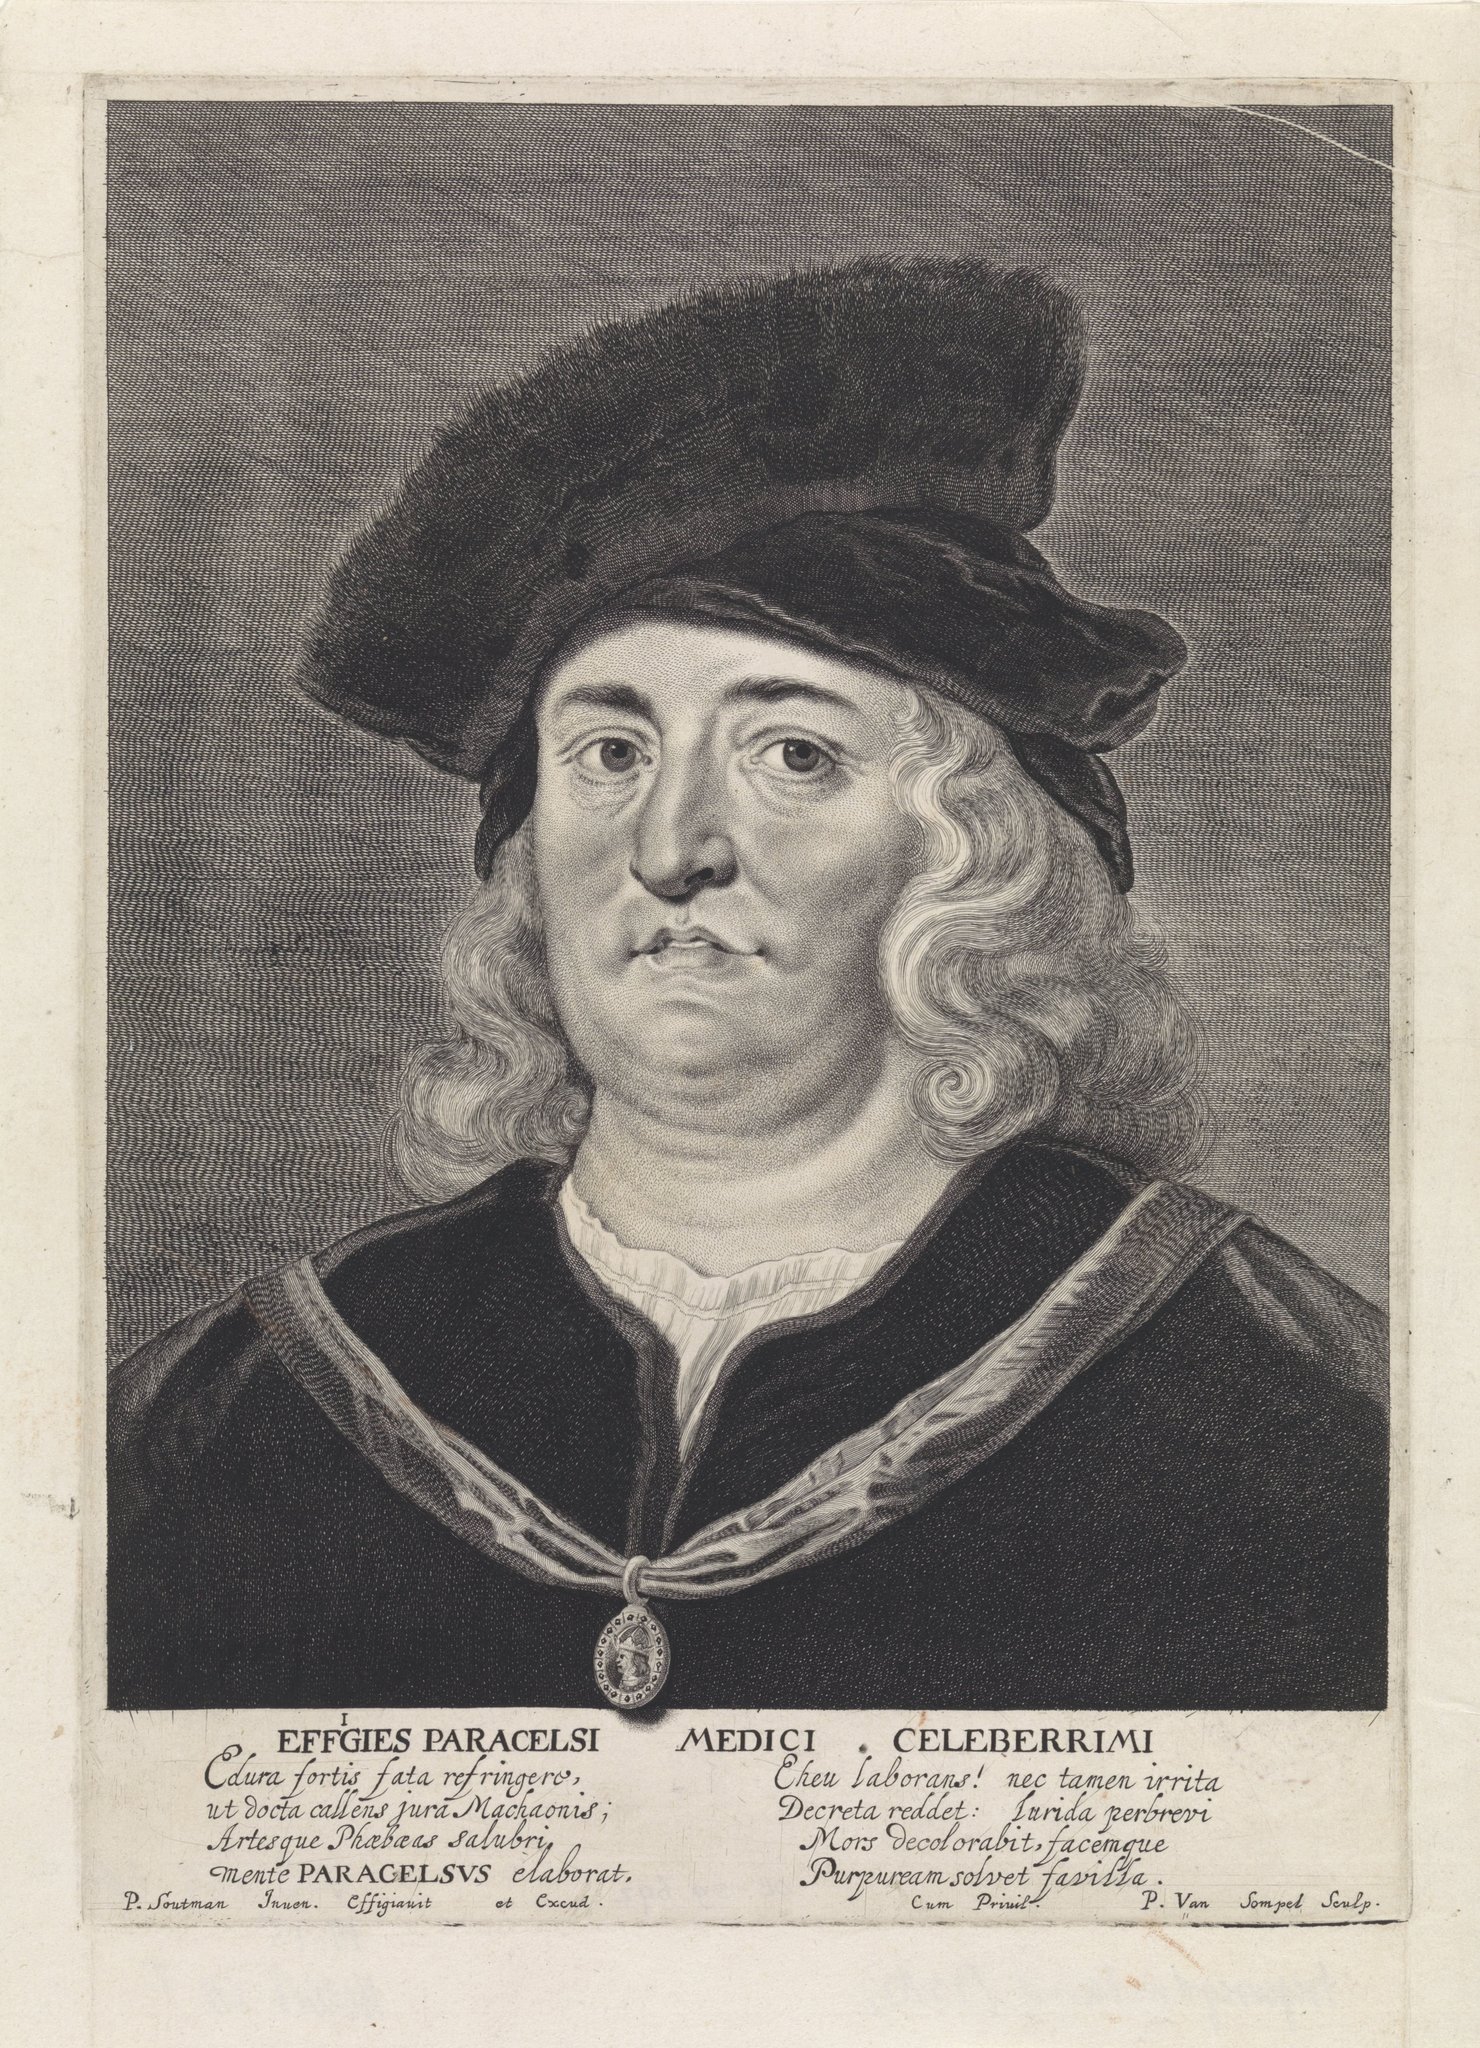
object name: print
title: Portret van Paracelsus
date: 1644-1650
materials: paper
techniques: engraving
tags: einsiedeln, salzburg, schrijver, medicus, chemicus, paracelsus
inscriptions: collector's mark: Lugt 240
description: Portret van de arts, theoloog en alchemist Paracelsus. Onder het portret zijn naam en een lofdicht in het Latijn.